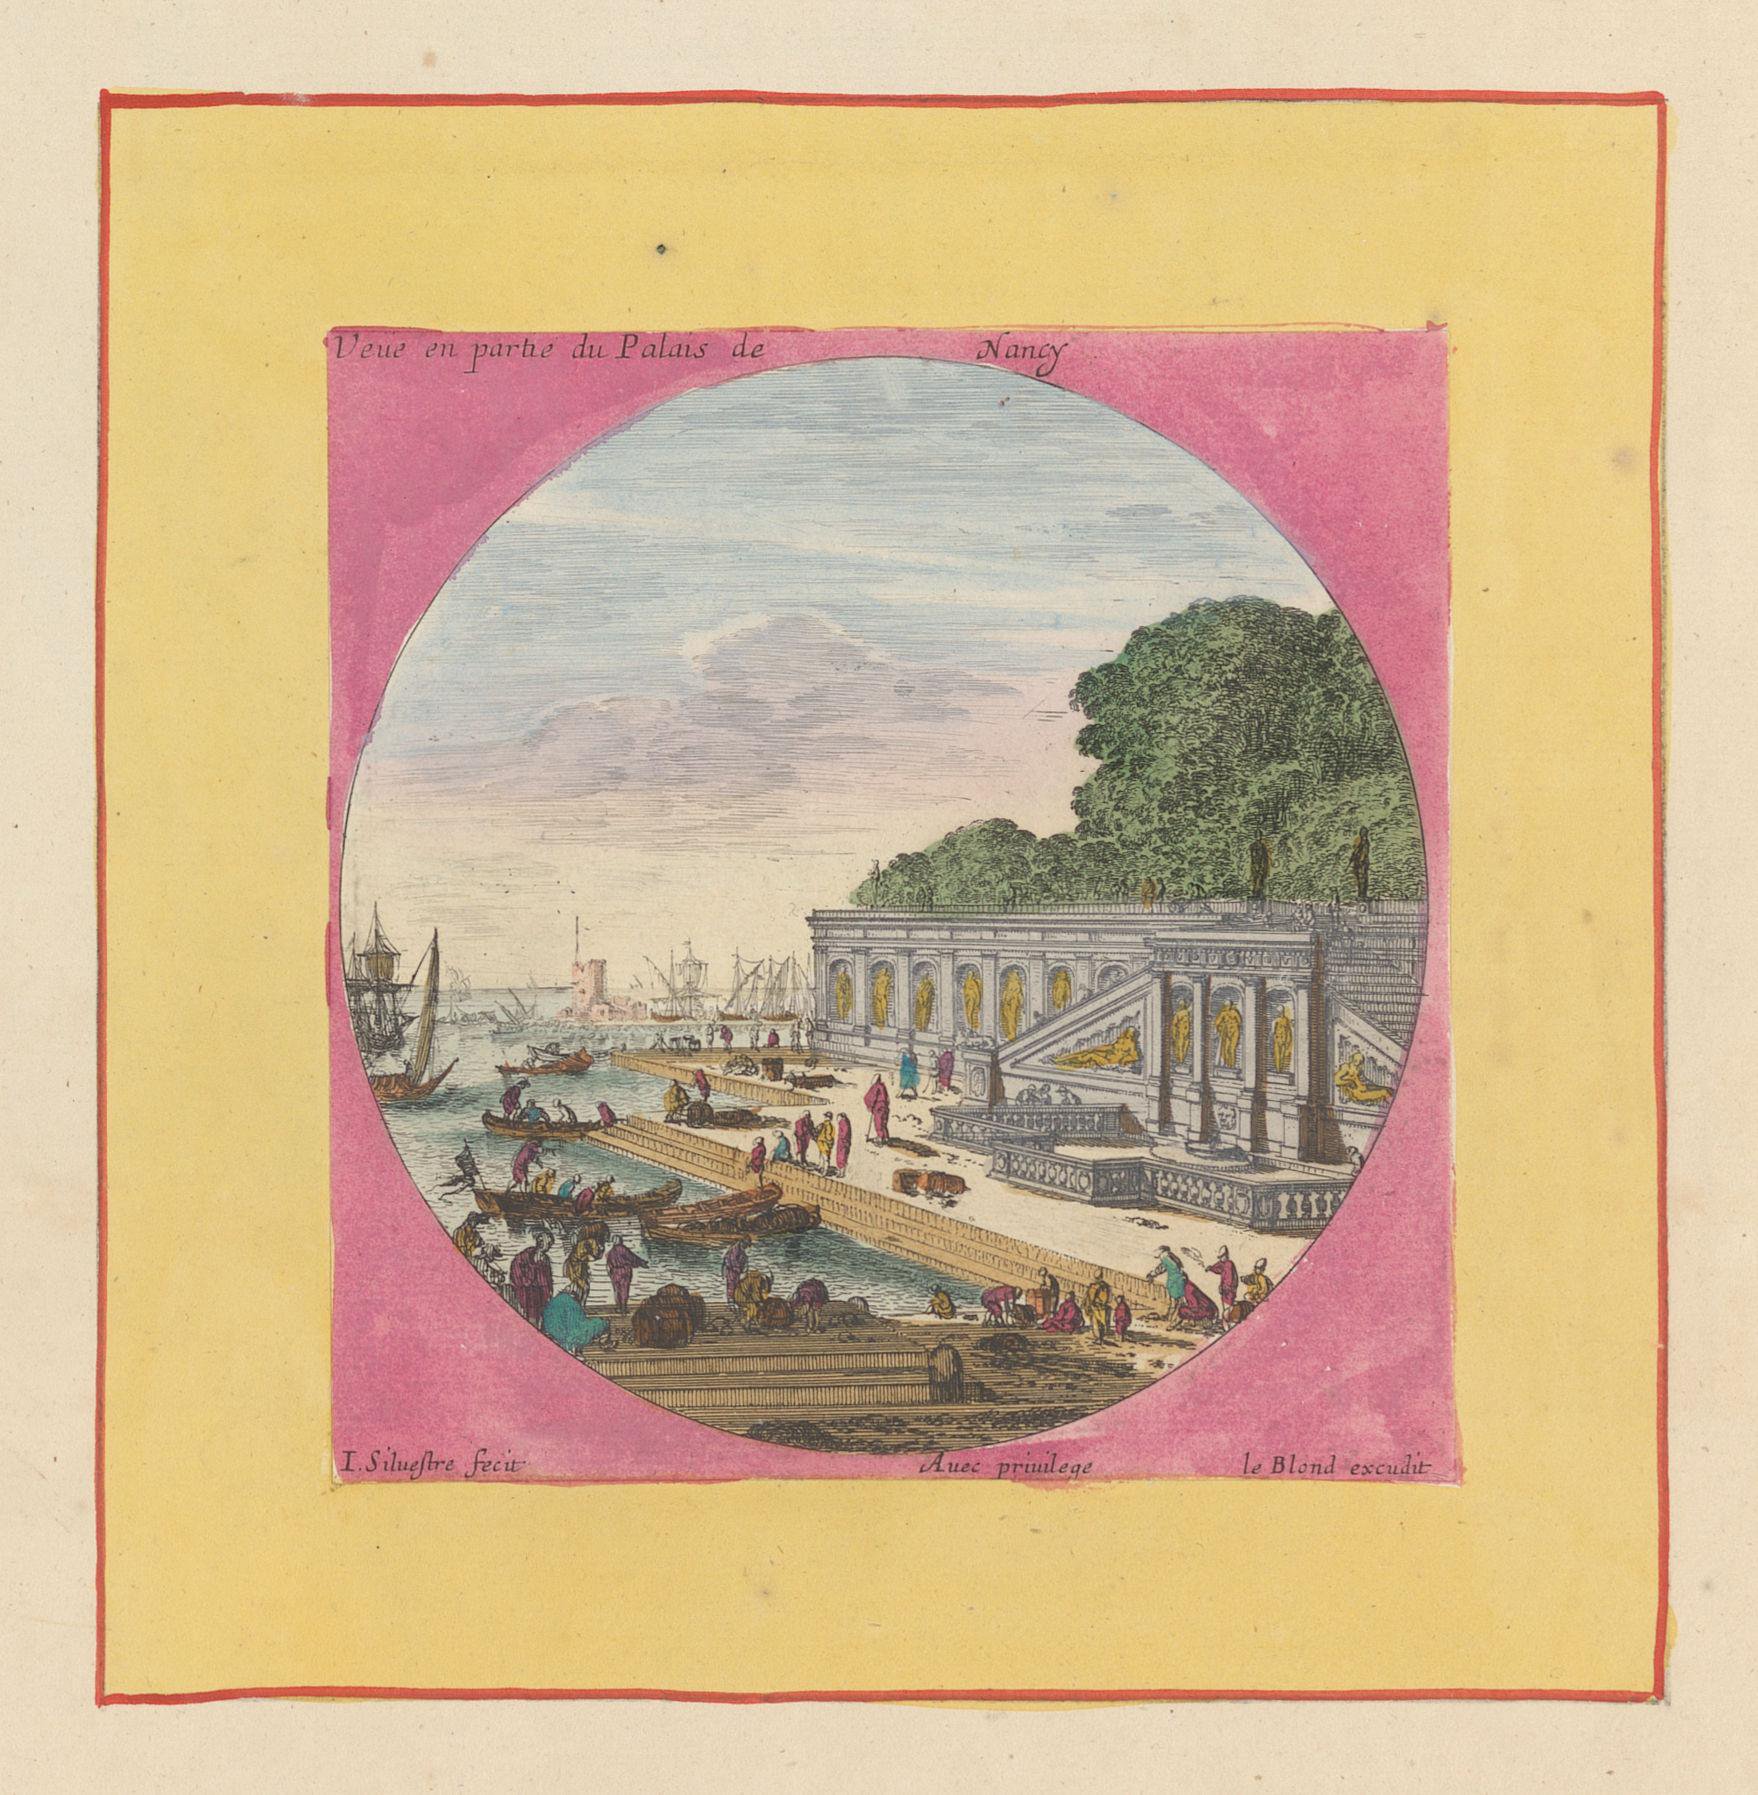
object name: print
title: Gezicht op het paleis van Nancy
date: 1635-1691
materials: paper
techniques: etching, hand coloring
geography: the hague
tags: landscape with bridge, viaduct or aqueduct, dock crane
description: Deze prent maakt deel uit van een album.